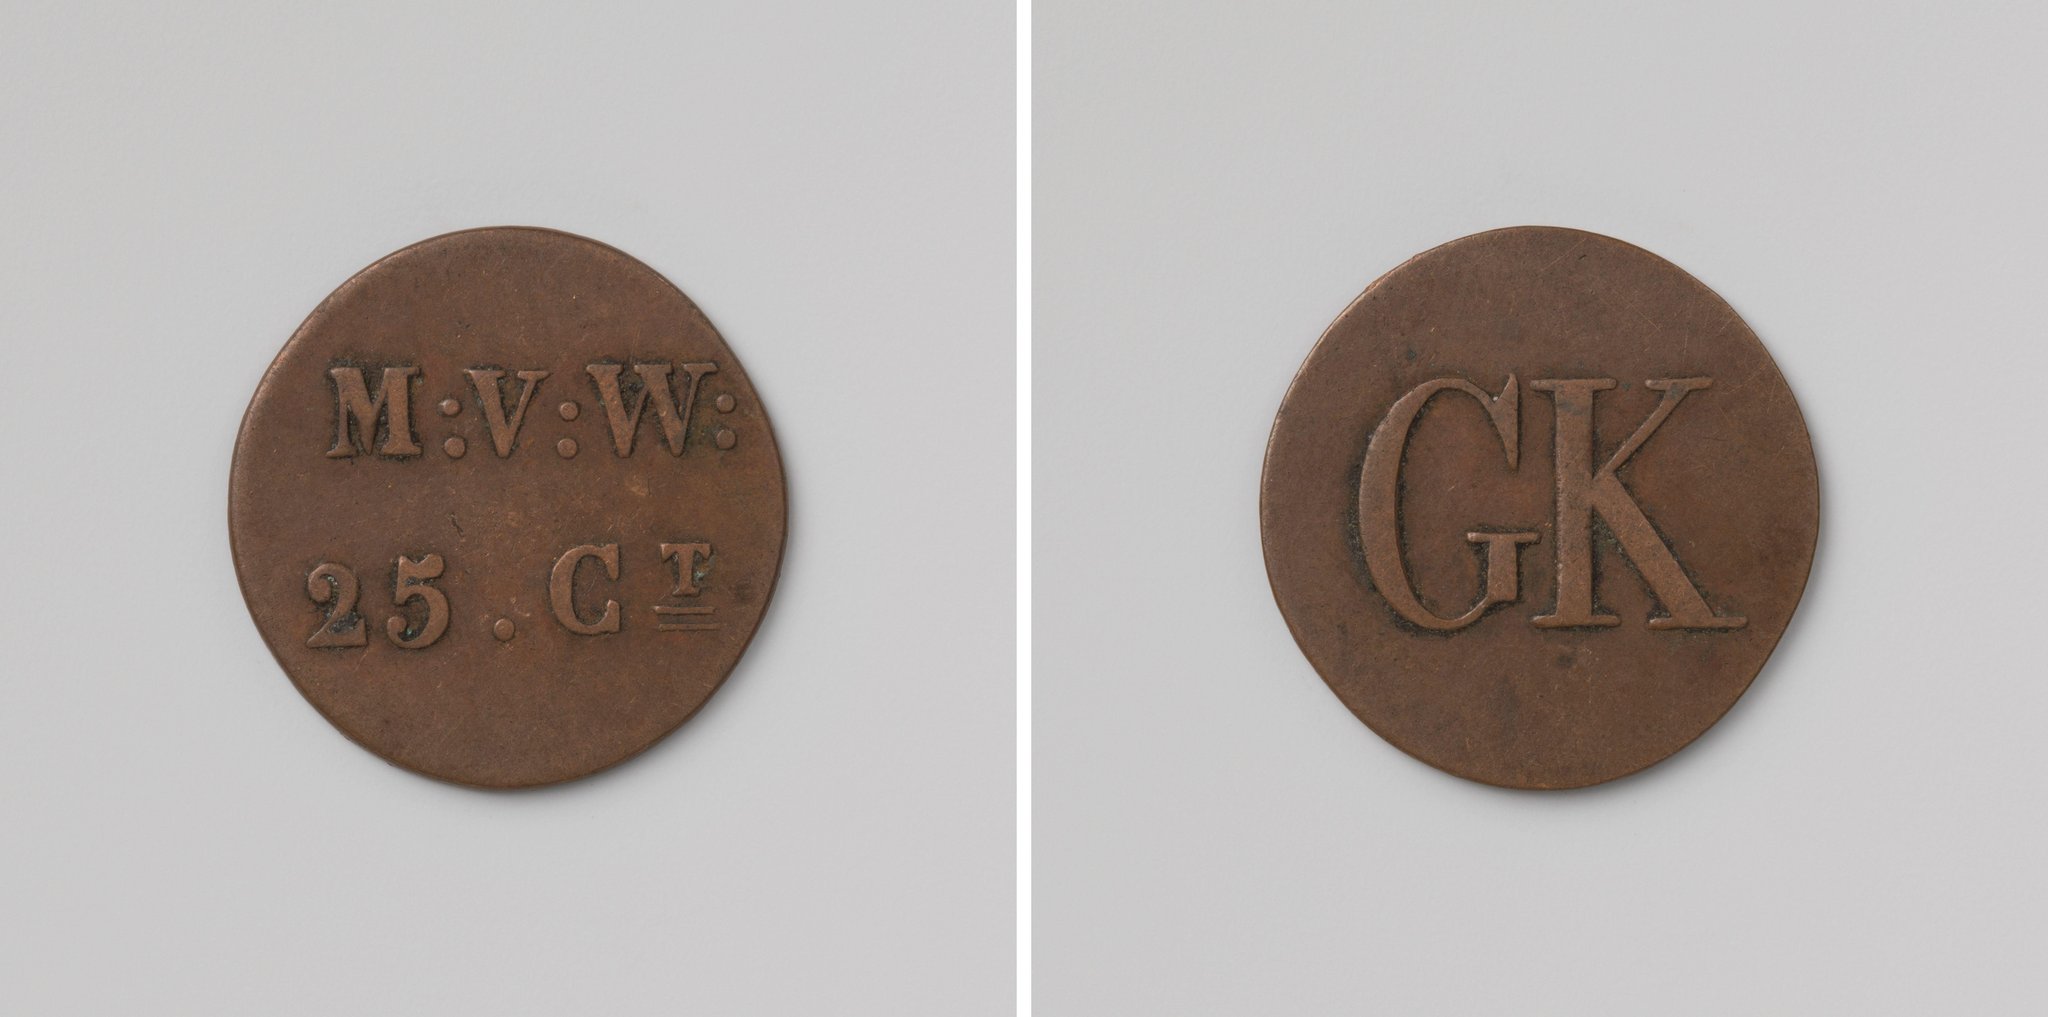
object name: monetary token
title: Huismunt geslagen op last van de Maatschappij van Weldadigheid ter waarde van 25 cent, ten behoeve van de Gewone Koloniën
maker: Anonymous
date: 1818-1859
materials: copper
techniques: striking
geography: netherlands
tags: maatschappij van weldadigheid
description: Voorzijde: opschrift boven waardeaanduiding. Keerzijde: opschrift G en K